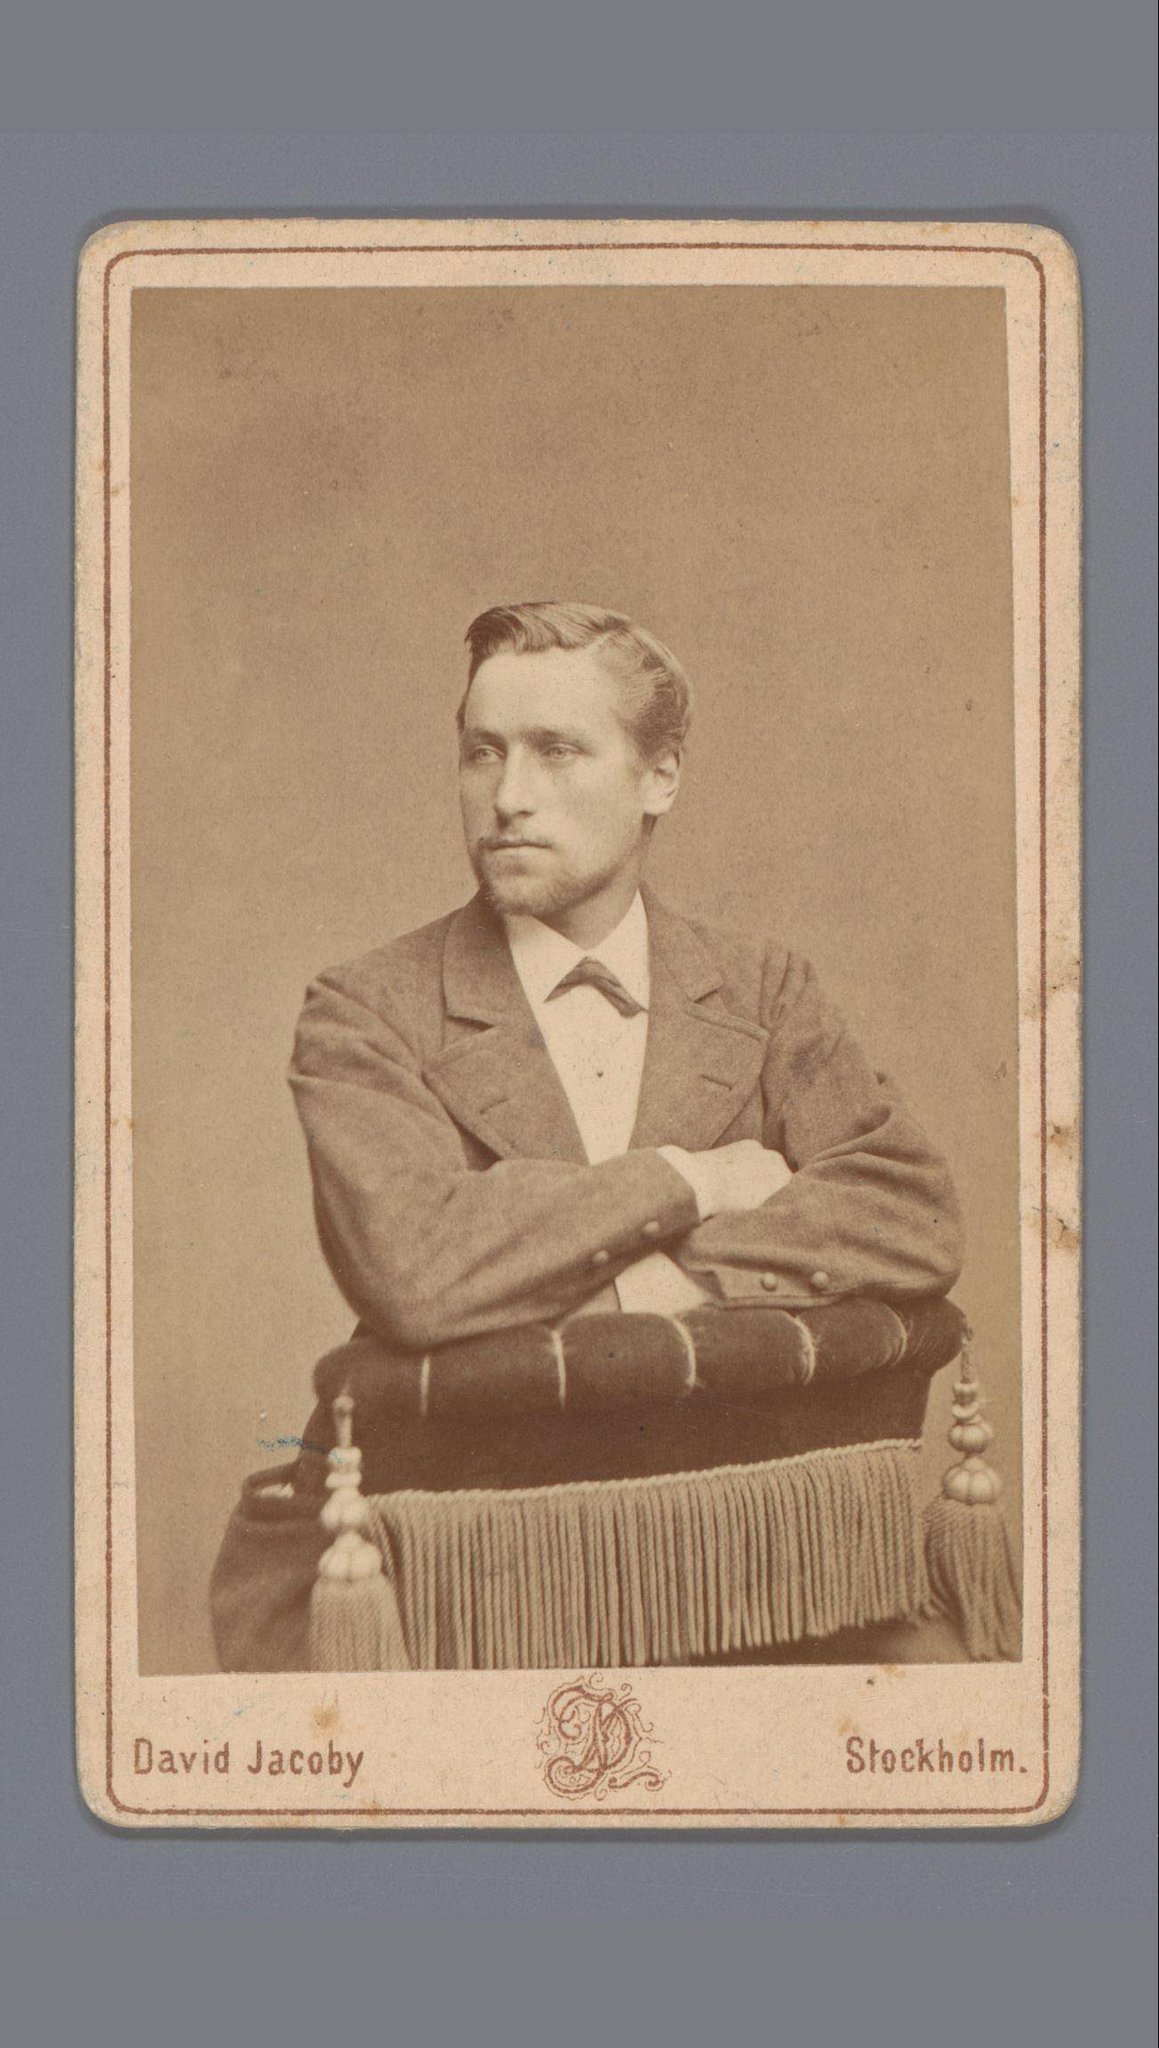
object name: photograph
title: Portret van een onbekende jongeman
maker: david jacoby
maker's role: fotograaf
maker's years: 1843-1879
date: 1872-1879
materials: cardboard, paper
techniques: albumen print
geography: stockholm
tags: sitting figure, historical persons, youth, adolescent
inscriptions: inscription: ‘DAVID JACOBY/ Fotografi-Atelier/ STOCKHOLM/ 80. Jerntorget 80./ Plåten förvaras för efterbeställning.’